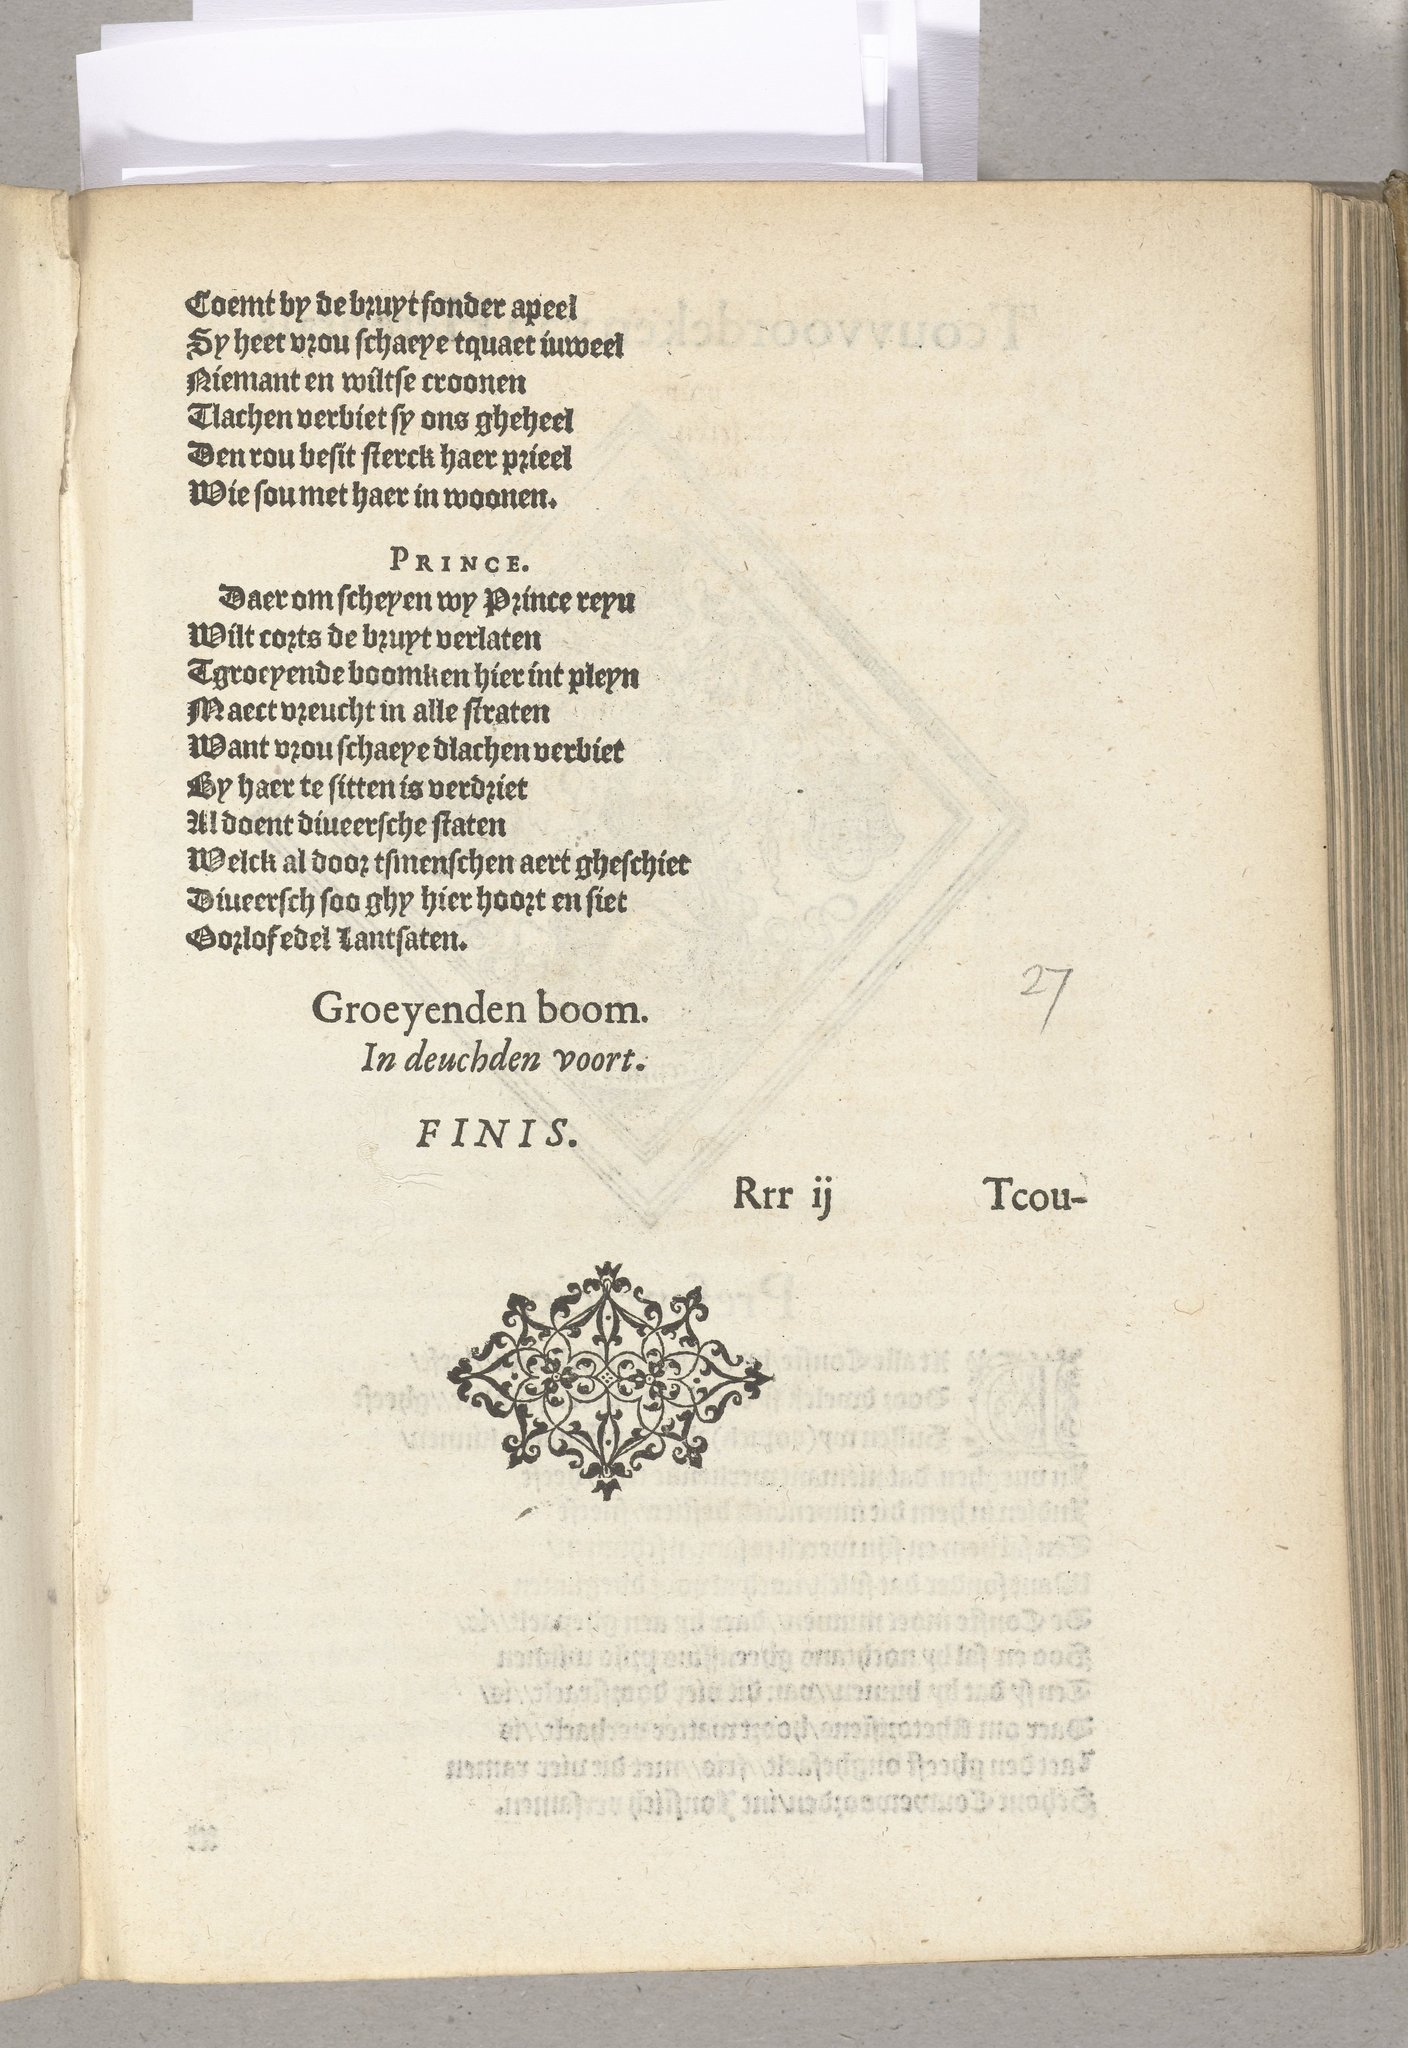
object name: print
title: Tcouwoordeken van Herentals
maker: Anonymous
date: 1561-1562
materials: paper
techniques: woodcut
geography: antwerp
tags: chamber of rhetoric (dutch: 'rederijkerskamer'), antwerp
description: Illustratie in: Spelen van sinne vol scoone moralisacien wtleggingen ende bediedenissen op alle loeflijcke consten waer inne men claerlijck ghelijck in eene spieghel, figuerlijck, poetelijck en retorijckelijck mach aenschouwen hoe nootsakelijck ende dienstelijck die selve consten allen menschen zijn : ghespeelt met octroy der Con. Ma. binnen der stadt van Andtwerpen op dLant-Juweel by die veerthien cameren van Retorijcken die hen daer ghepresenteert hebben den derden dach Augusti int Jaer ons Heeren 1561, op die questie : wat den mensch aldermeest tot conste verwect. Uitgave van 1562, p. Rrr (2). In het exemplaar in de Rijksmuseum Research Library, signatuur: 325 D 20.